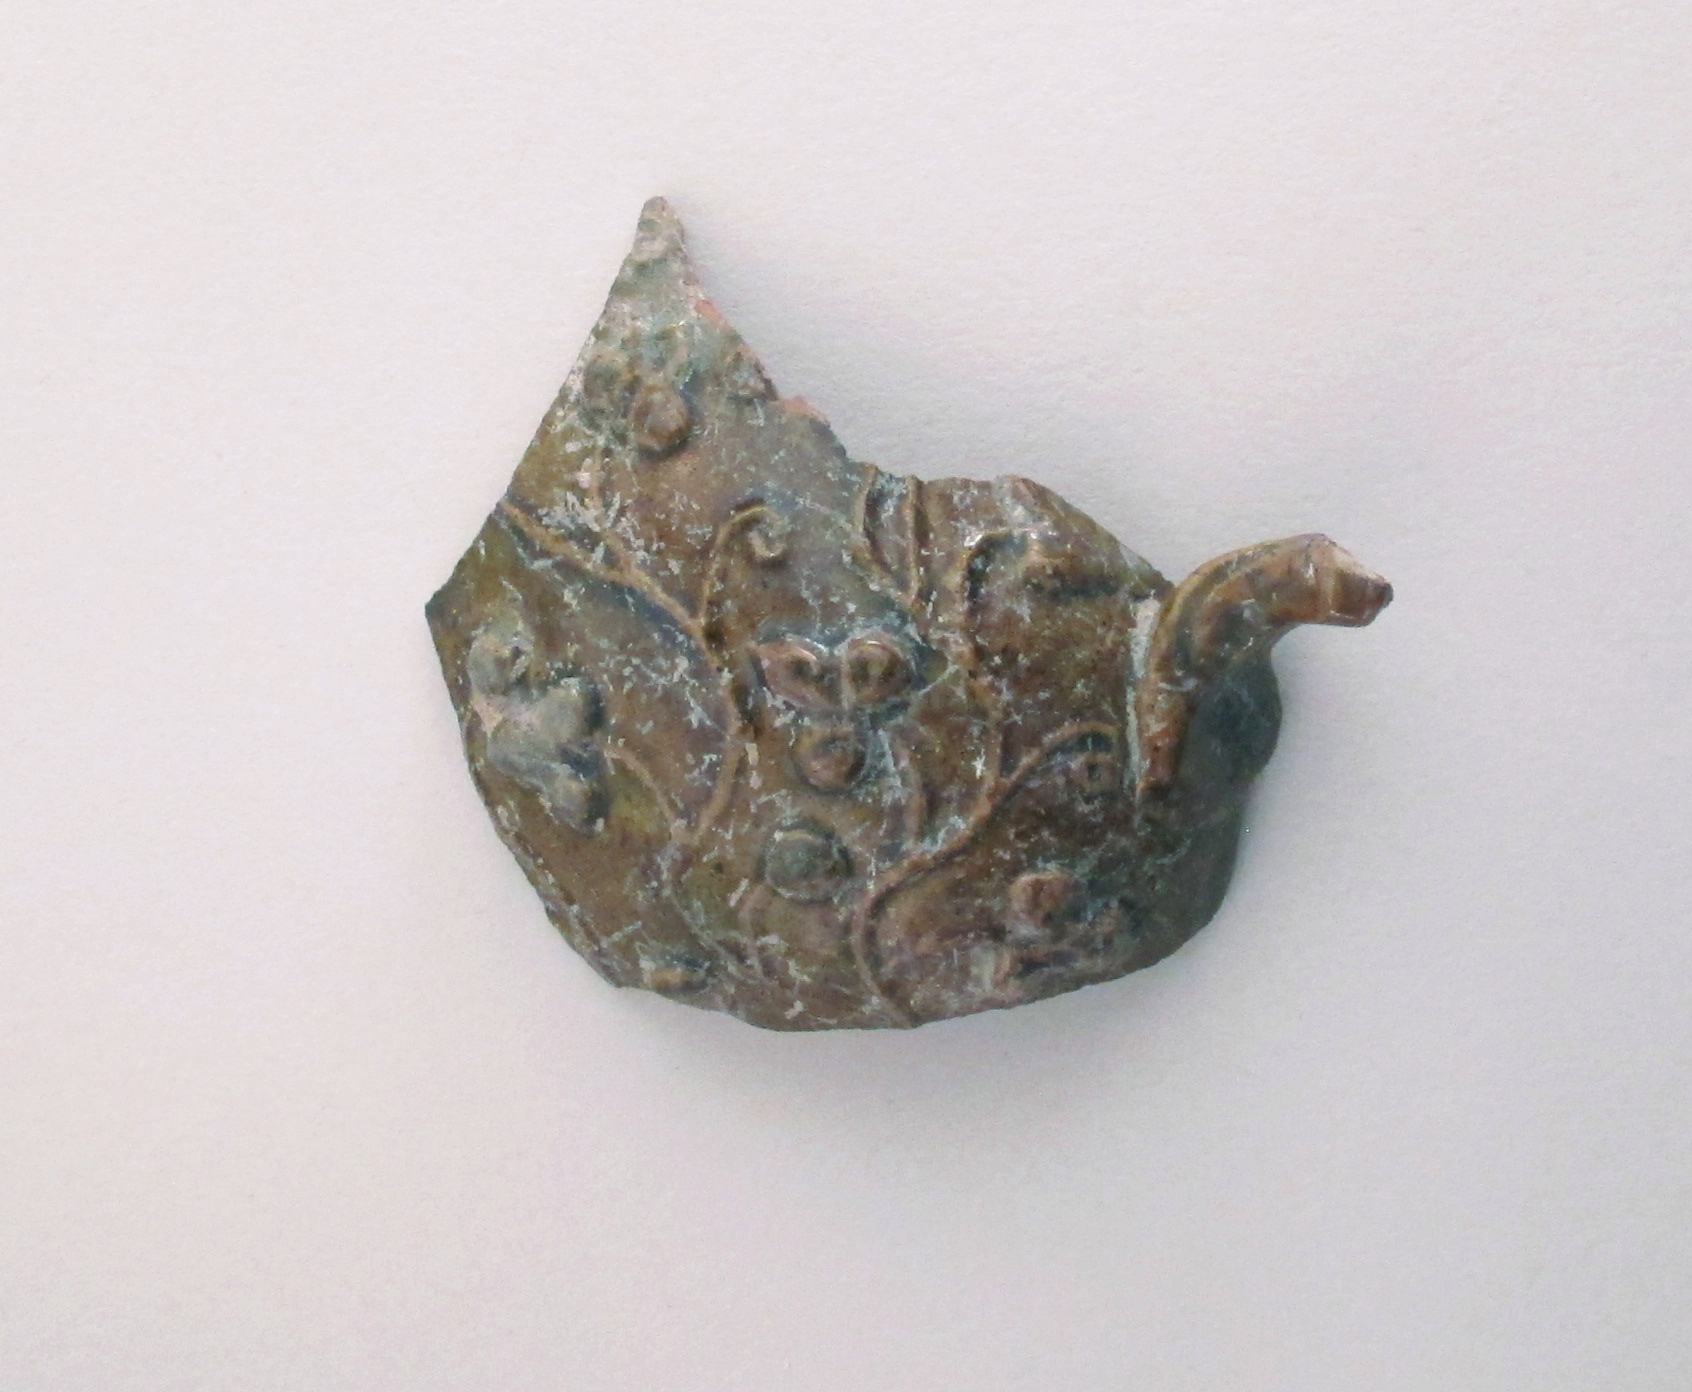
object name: vase fragment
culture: roman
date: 670 BCE-330 CE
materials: terracotta